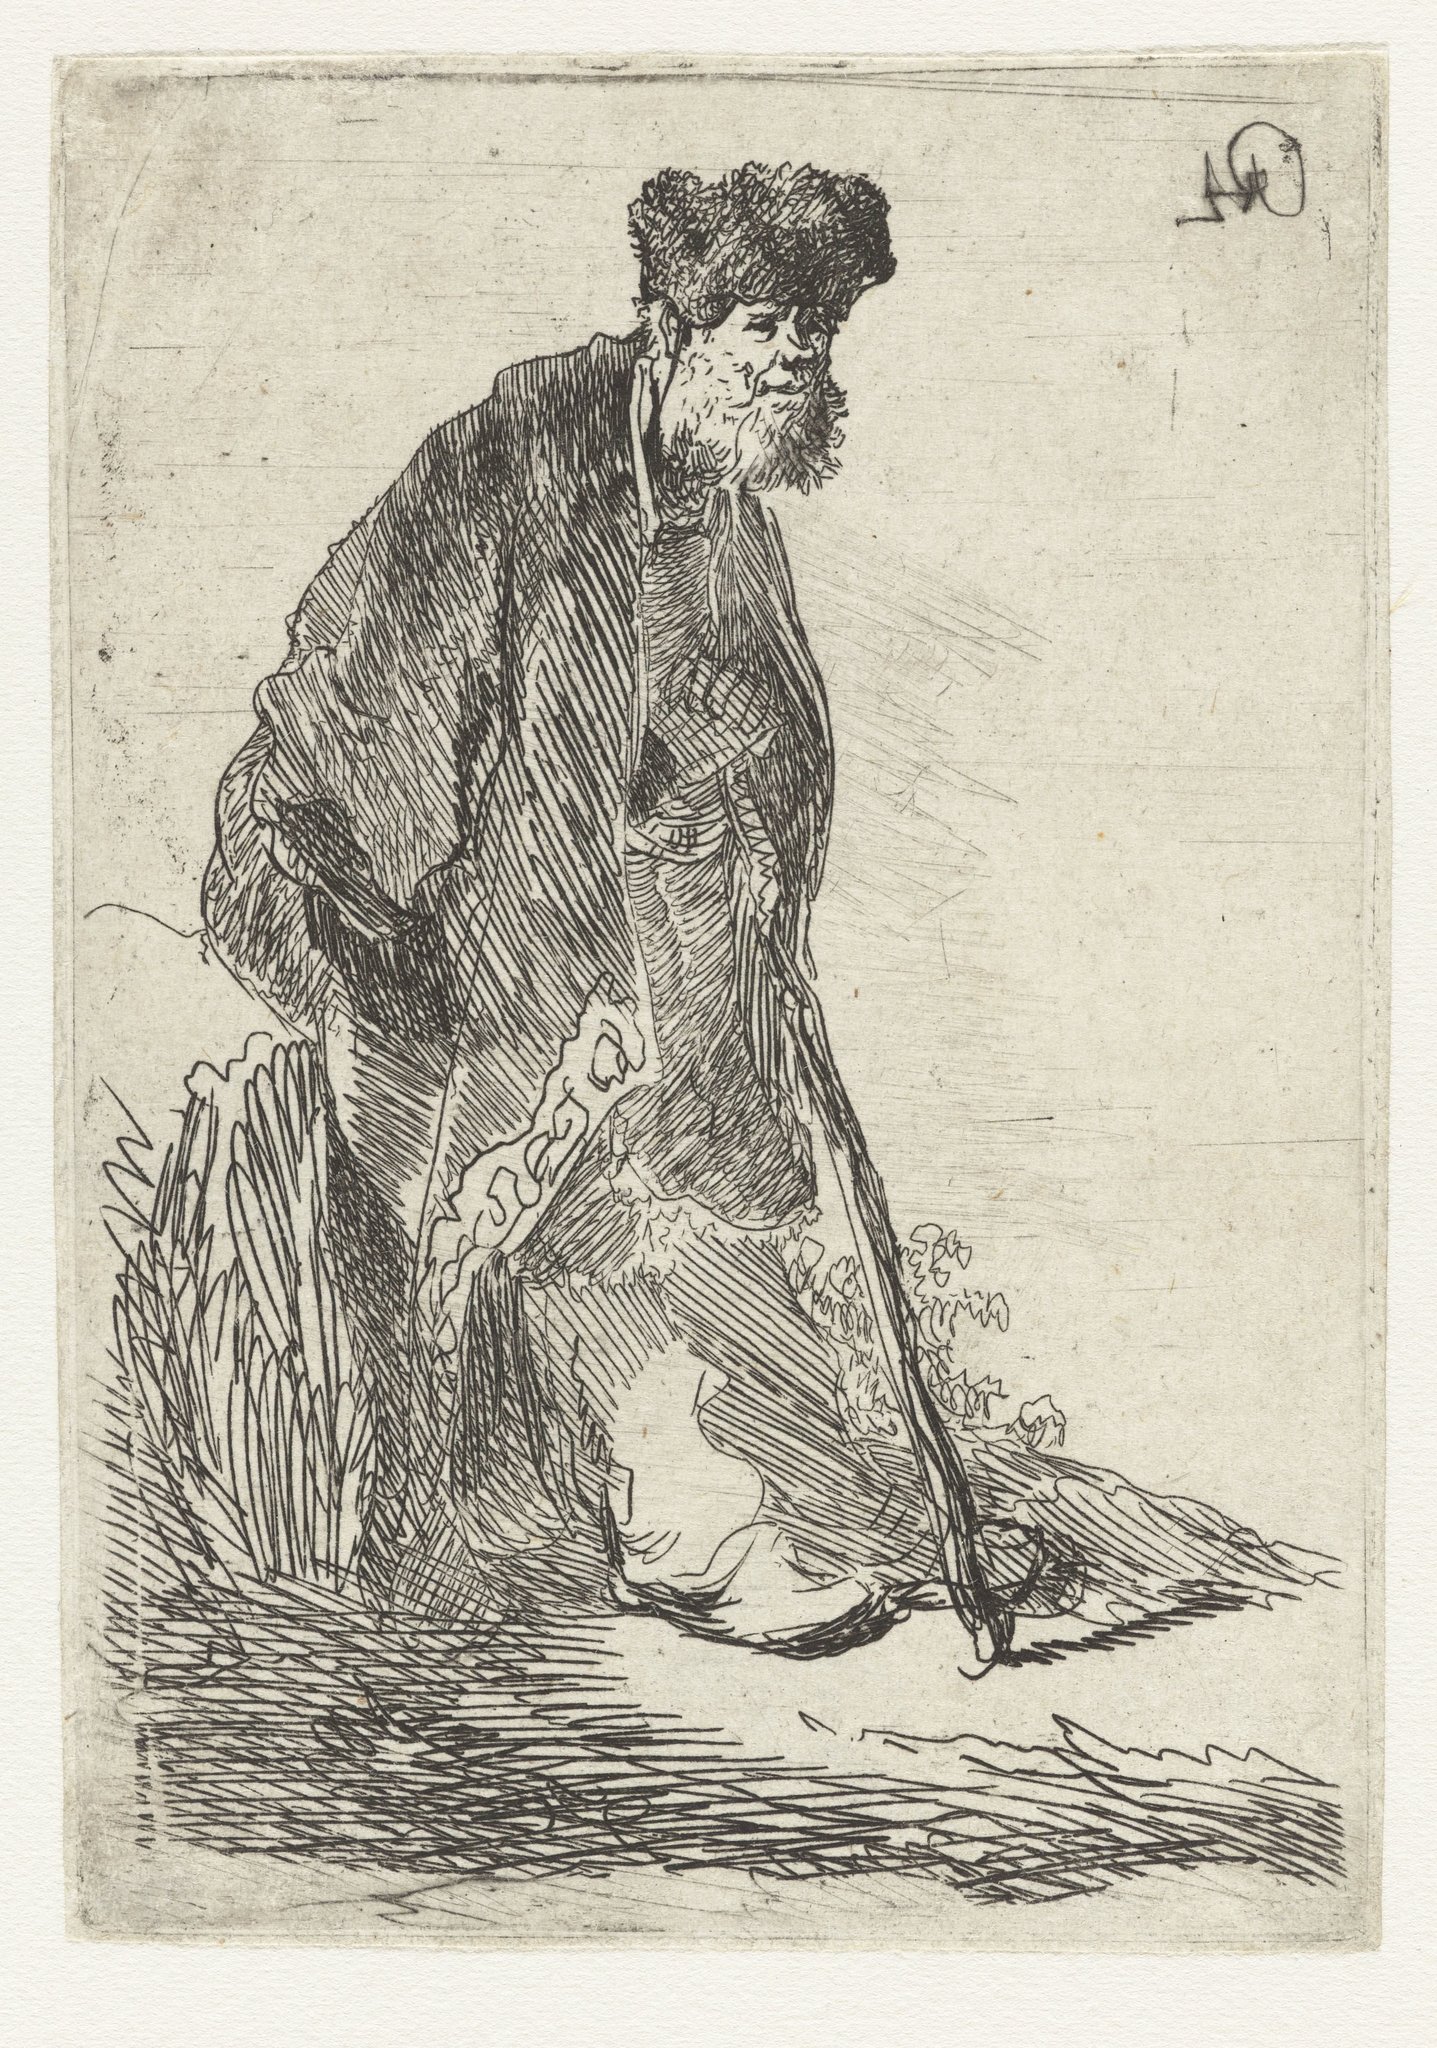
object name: print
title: Man in a coat and fur cap leaning against a bank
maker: rembrandt van rijn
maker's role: draughtsman, painter, print maker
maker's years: 1606-1669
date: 1630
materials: paper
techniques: etching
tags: head-gear (with name)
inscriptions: monogram: ‘RHL (spiegelbeeldig)’, mark: Lugt 2228